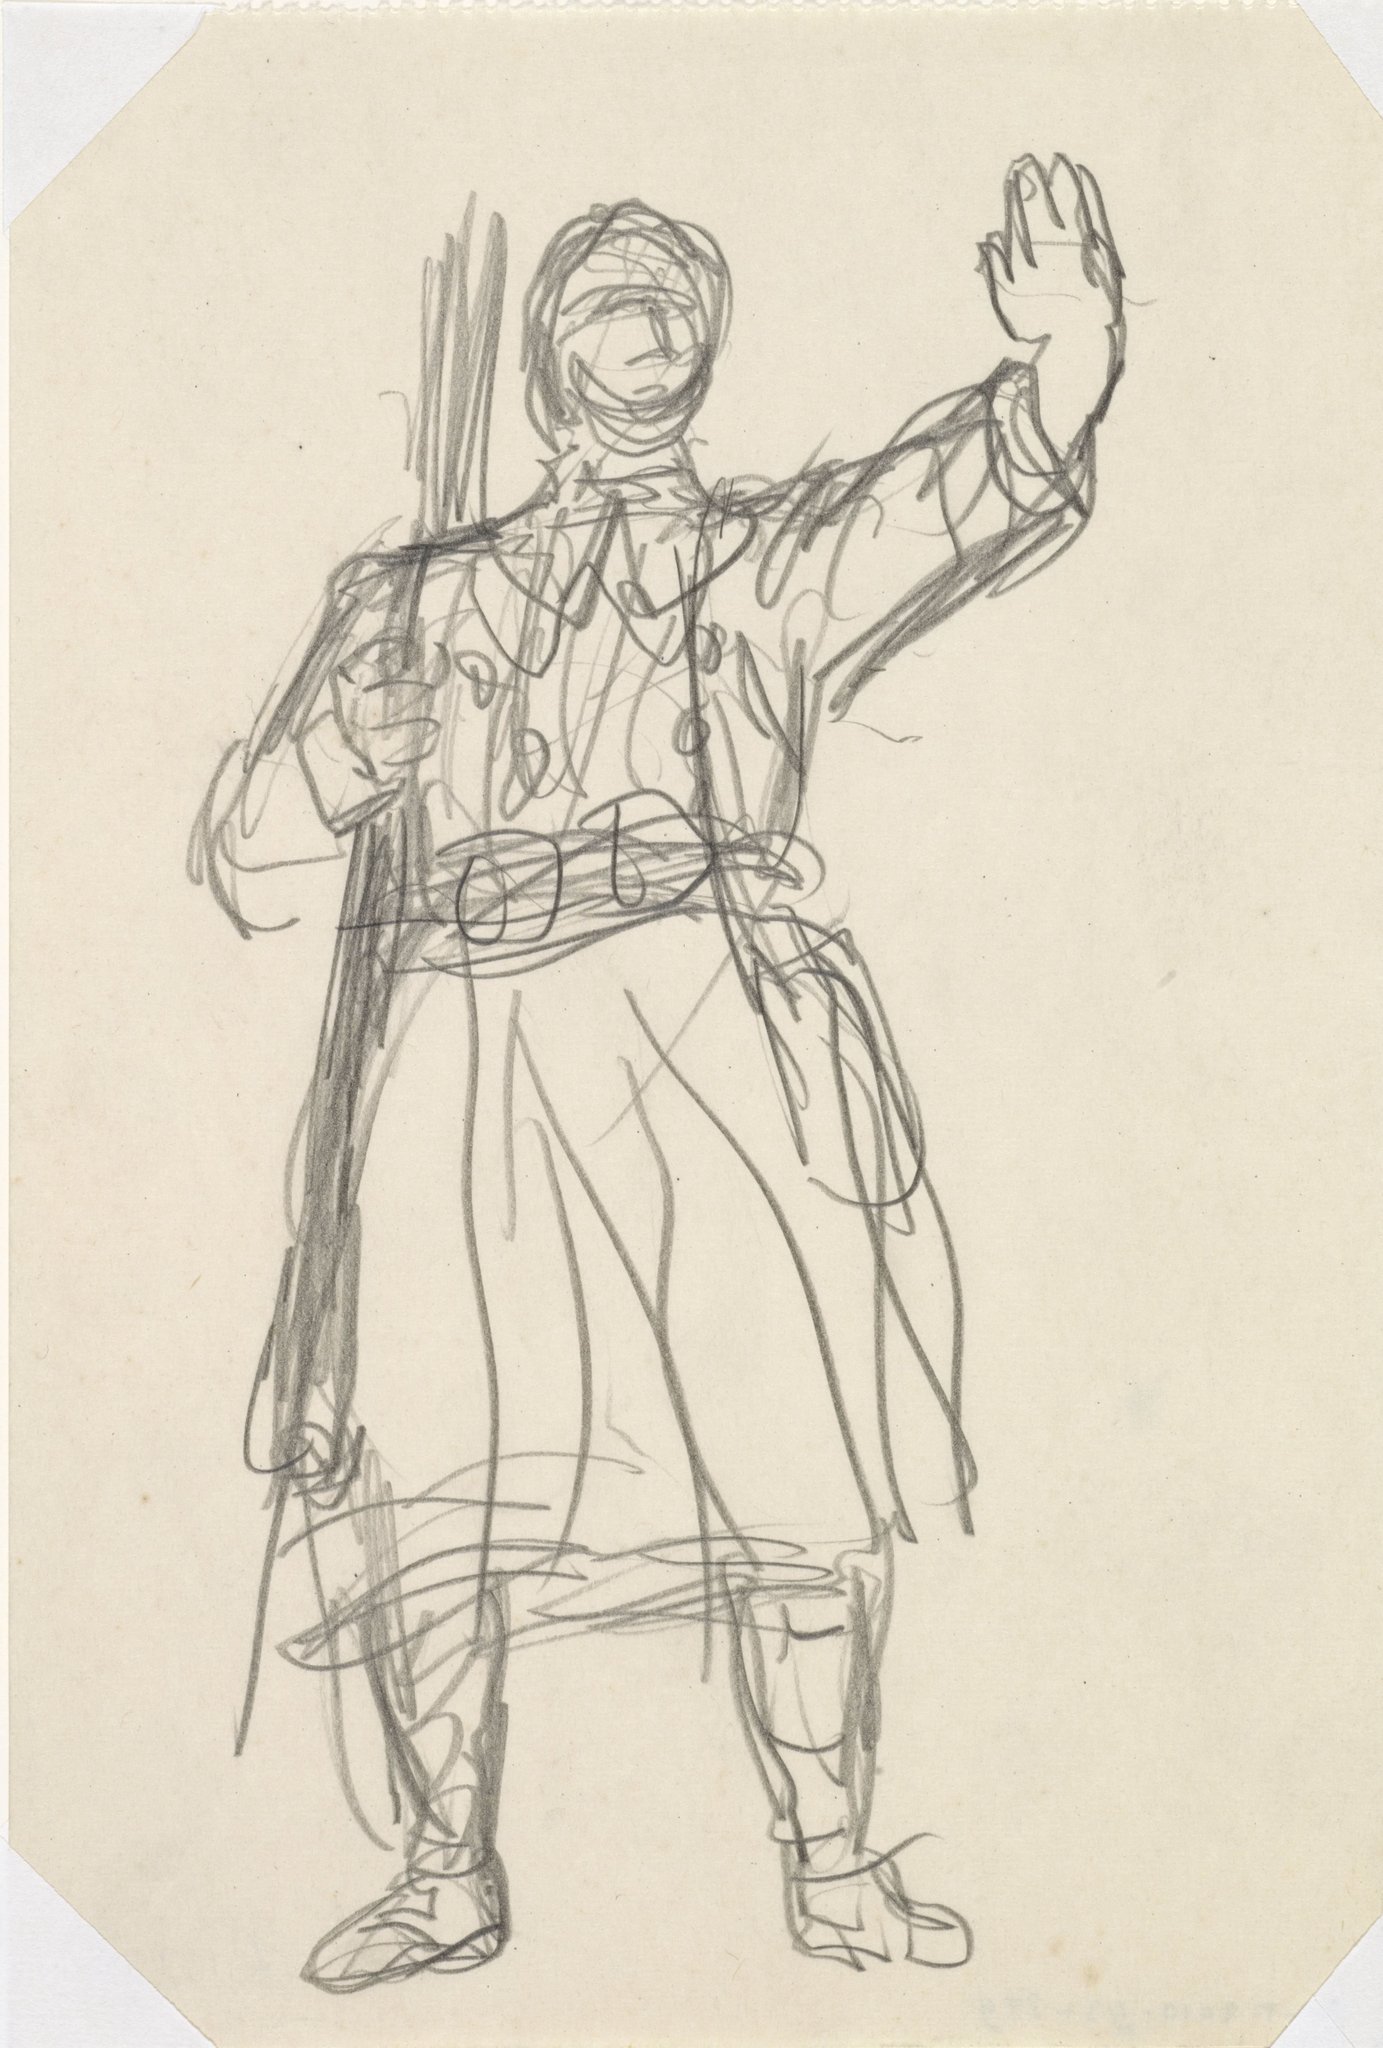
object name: sketch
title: Ontwerpschets affiche voor propaganda kunstbescherming in het leger, schets van soldaat, die met de linkerhand een stopteken maakt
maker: leo gestel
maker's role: draughtsman, print maker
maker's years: 1881-1941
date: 1939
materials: paper, pencil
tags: non-combatants ~ war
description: Soldaat frontaal gezien, die met linkerhand een stopteken maakt en een geweer over de rechterschouder draagt.